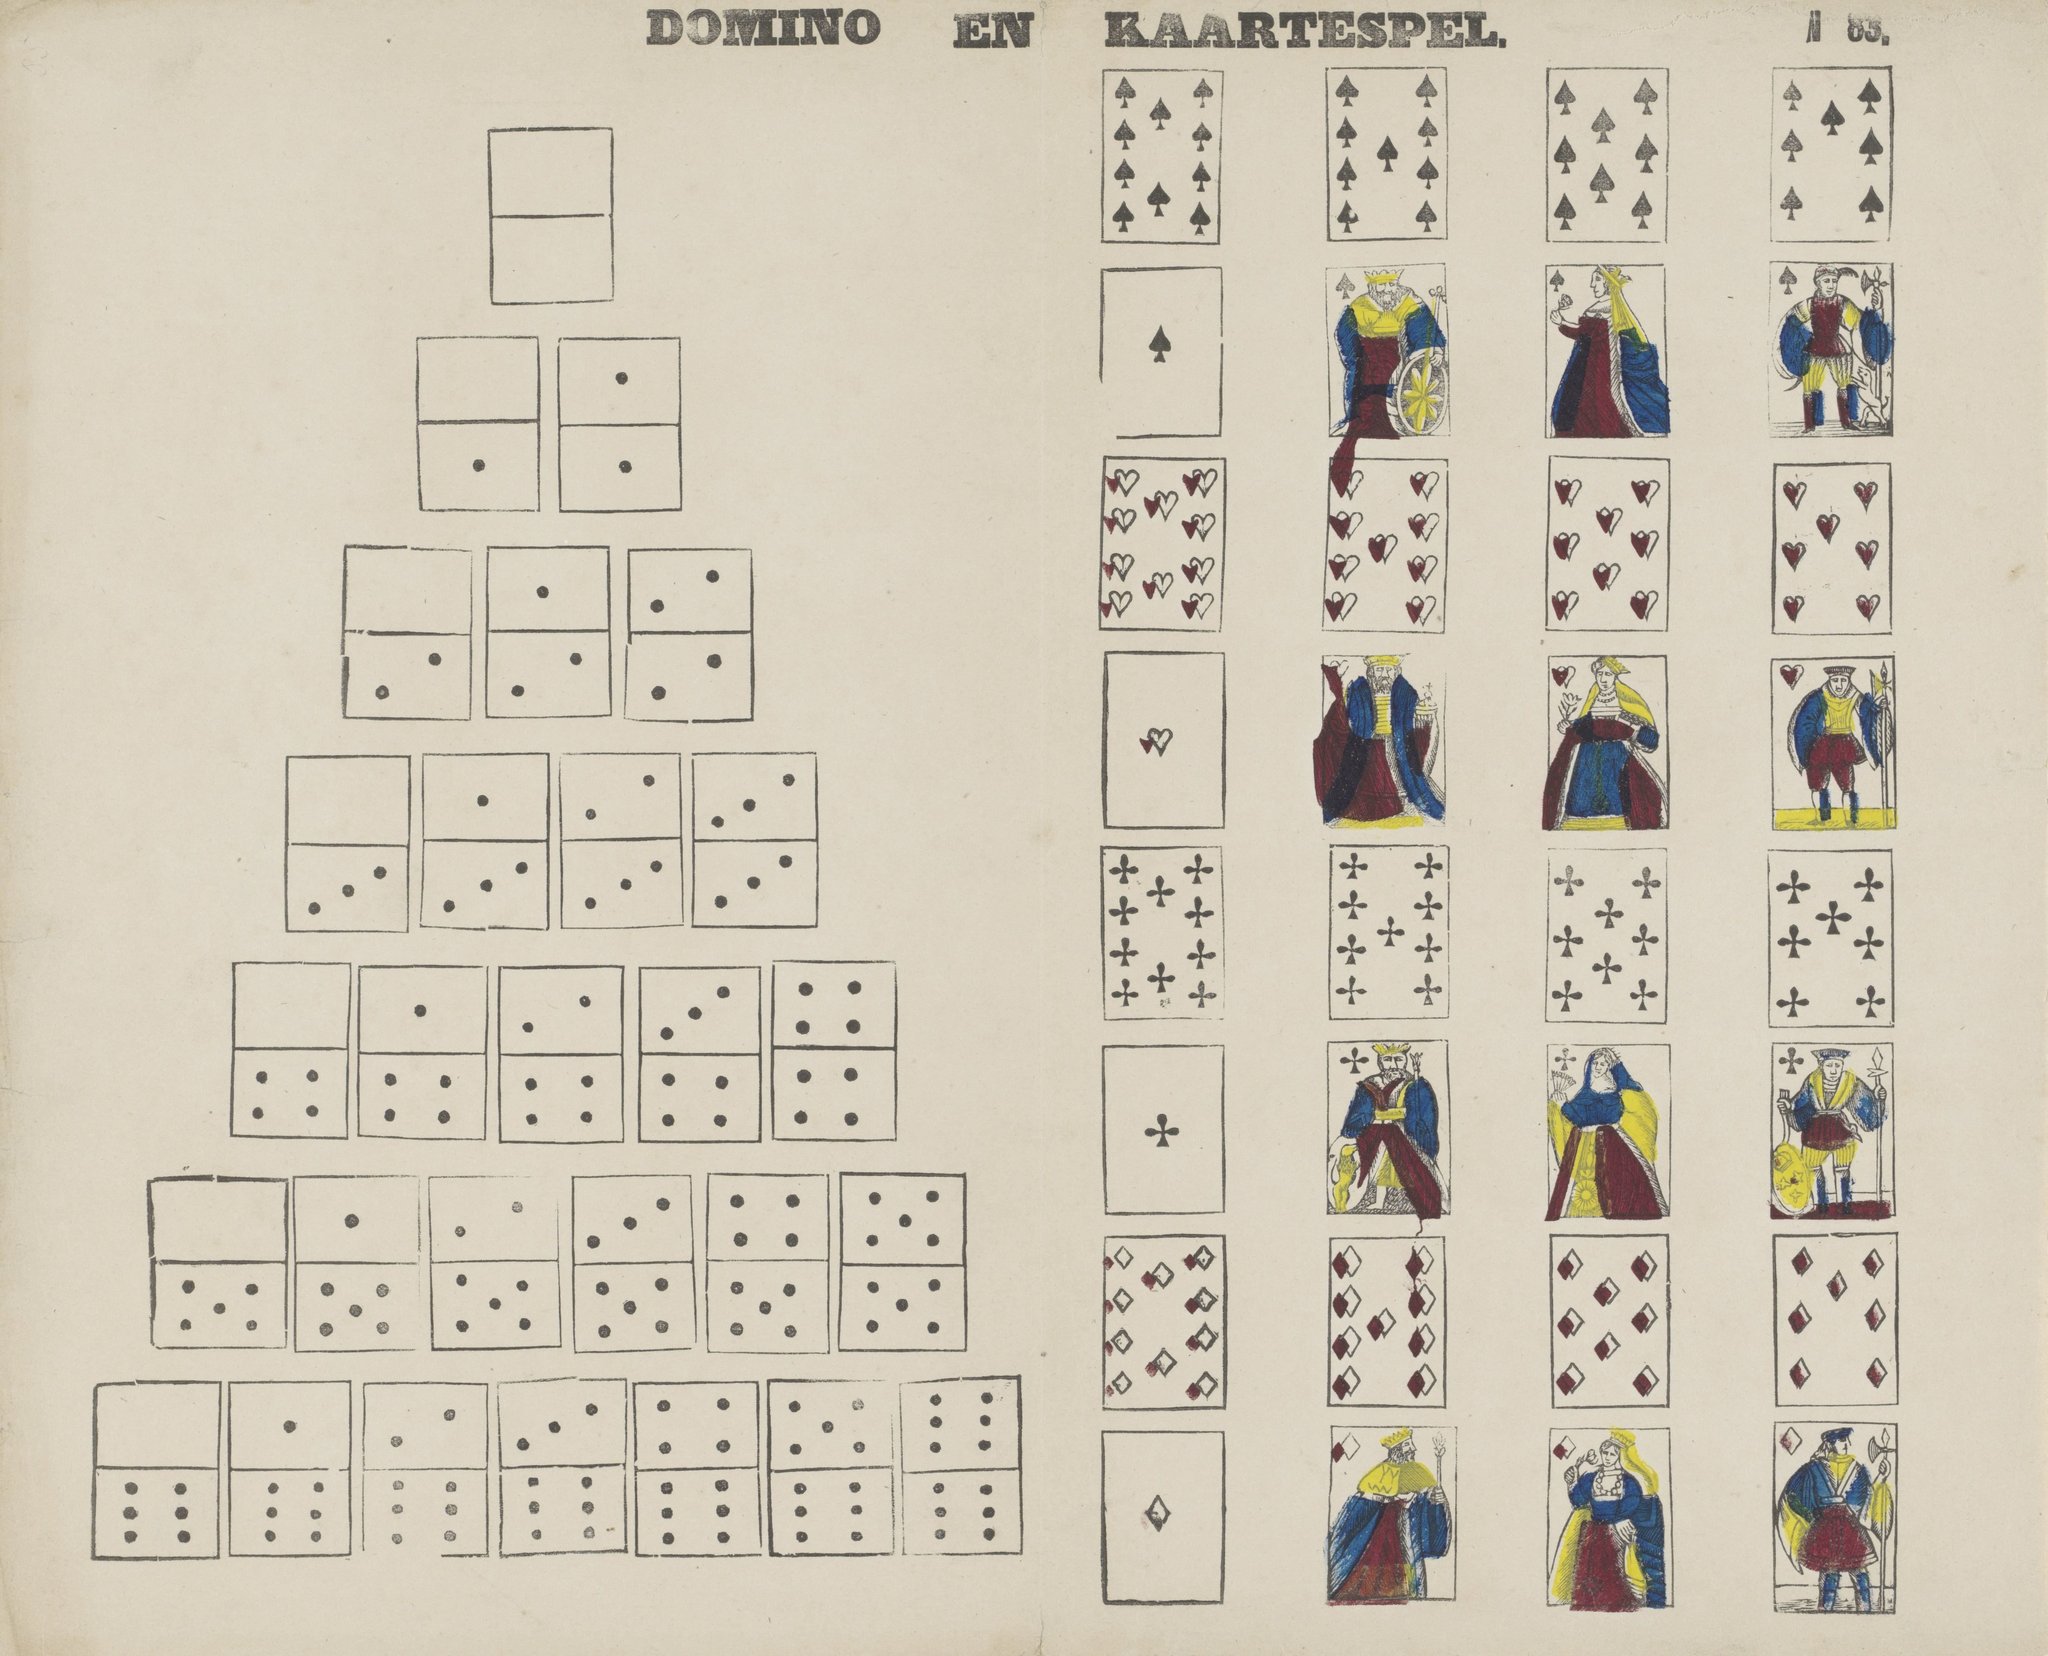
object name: print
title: Domino en kaartespel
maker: Anonymous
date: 1848-1881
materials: paper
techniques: colour, letterpress printing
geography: den bosch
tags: dominoes, playing-cards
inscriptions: collector's mark: Lugt 2760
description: Blad met 32 speelkaarten en 28 dominostenen om uit te knippen. Genummerd rechtsboven: N. 83.